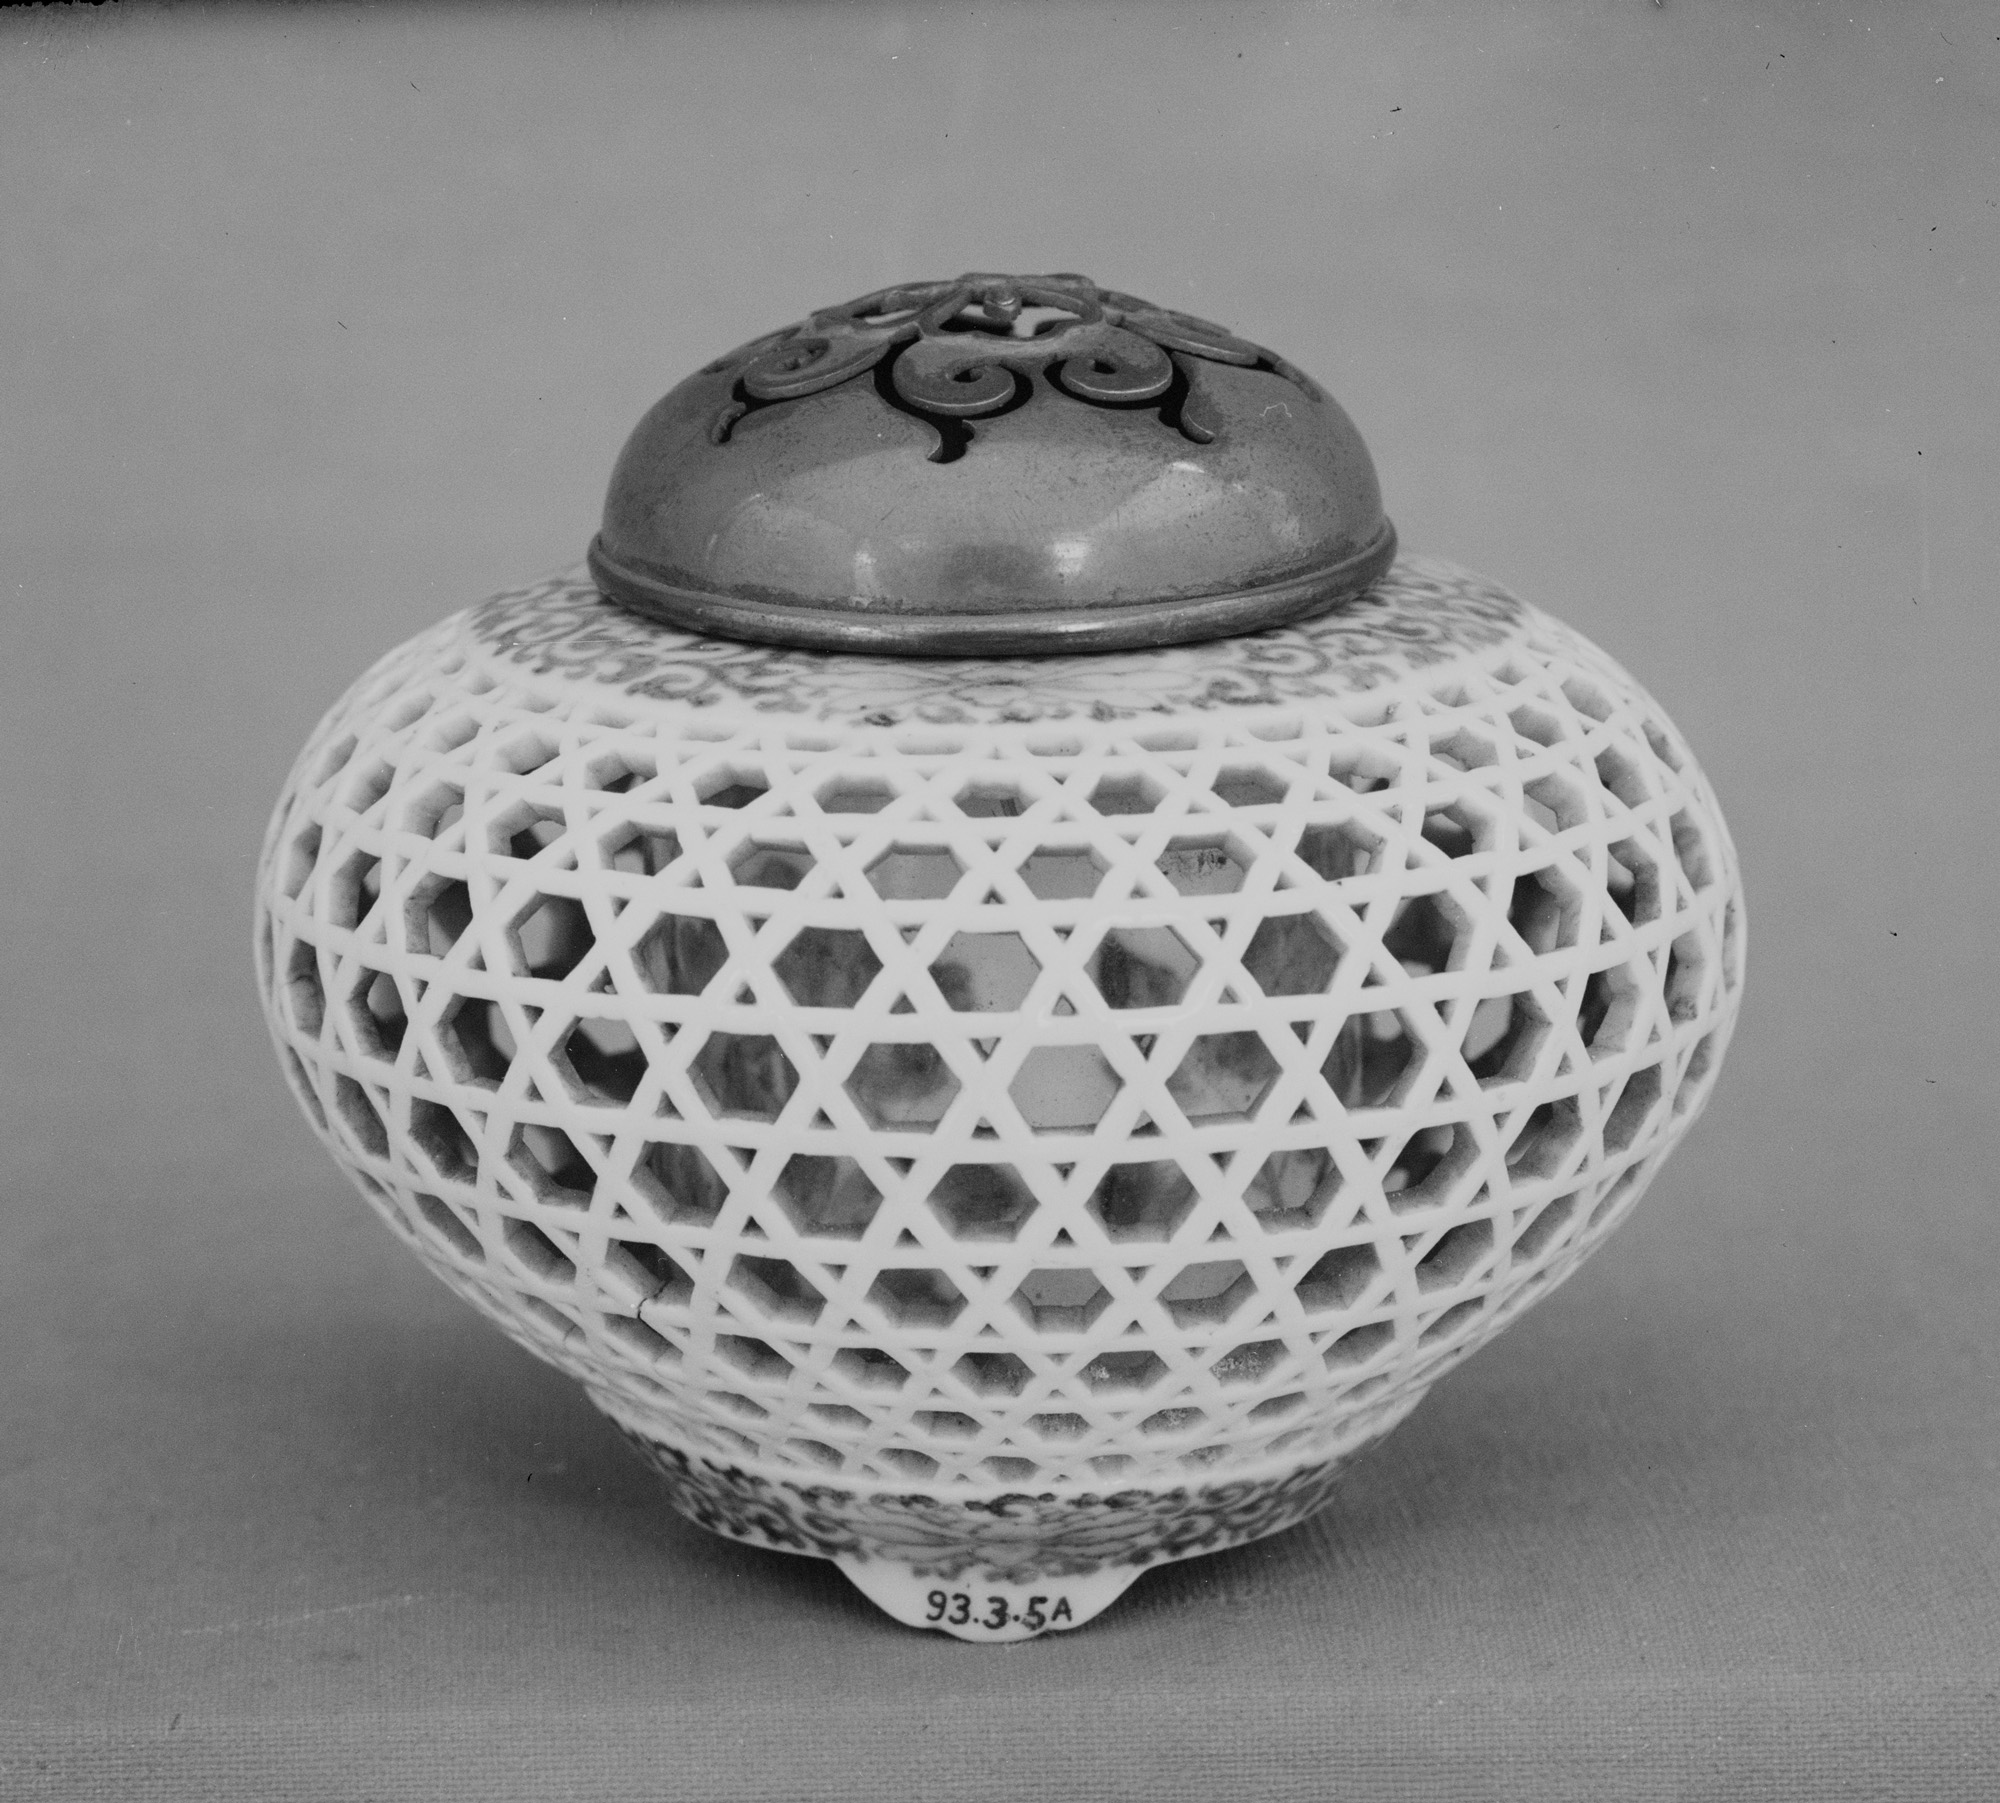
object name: incense burner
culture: japanese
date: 1780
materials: glaze, porcelain